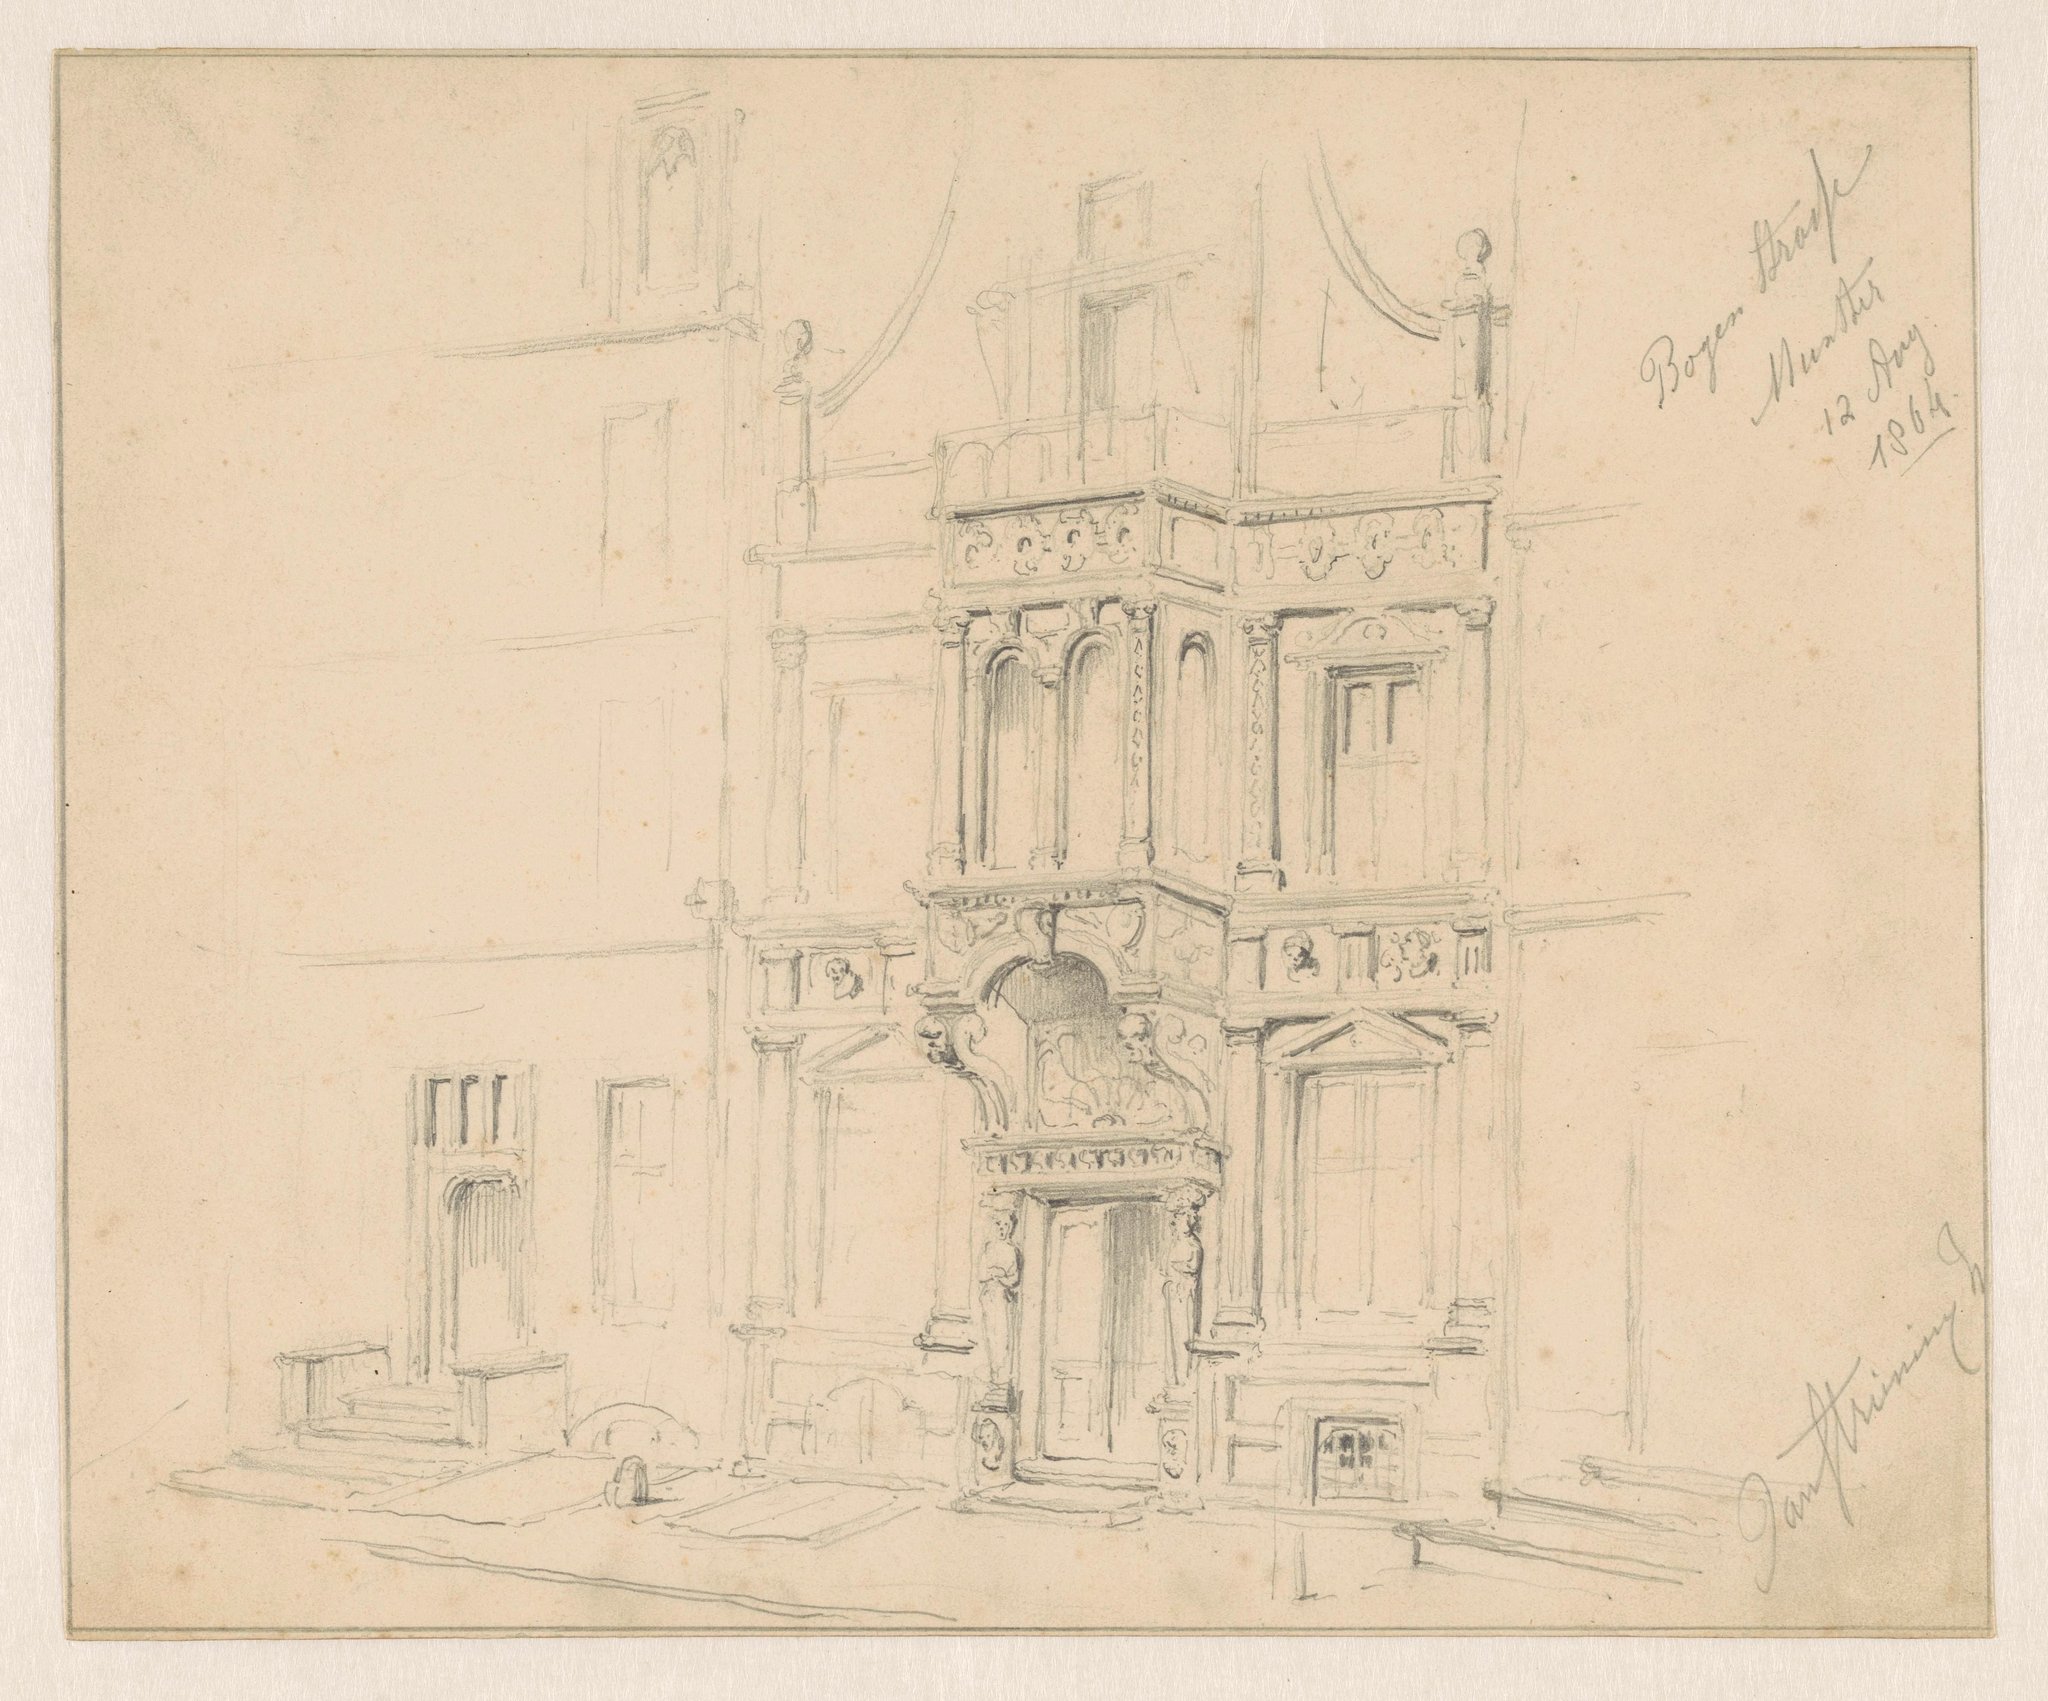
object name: drawing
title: Façade met erker in de Bogenstrasze te Münster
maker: jan striening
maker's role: draughtsman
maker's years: 1827-1903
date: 1864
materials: paper, pencil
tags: façade (of house or building)